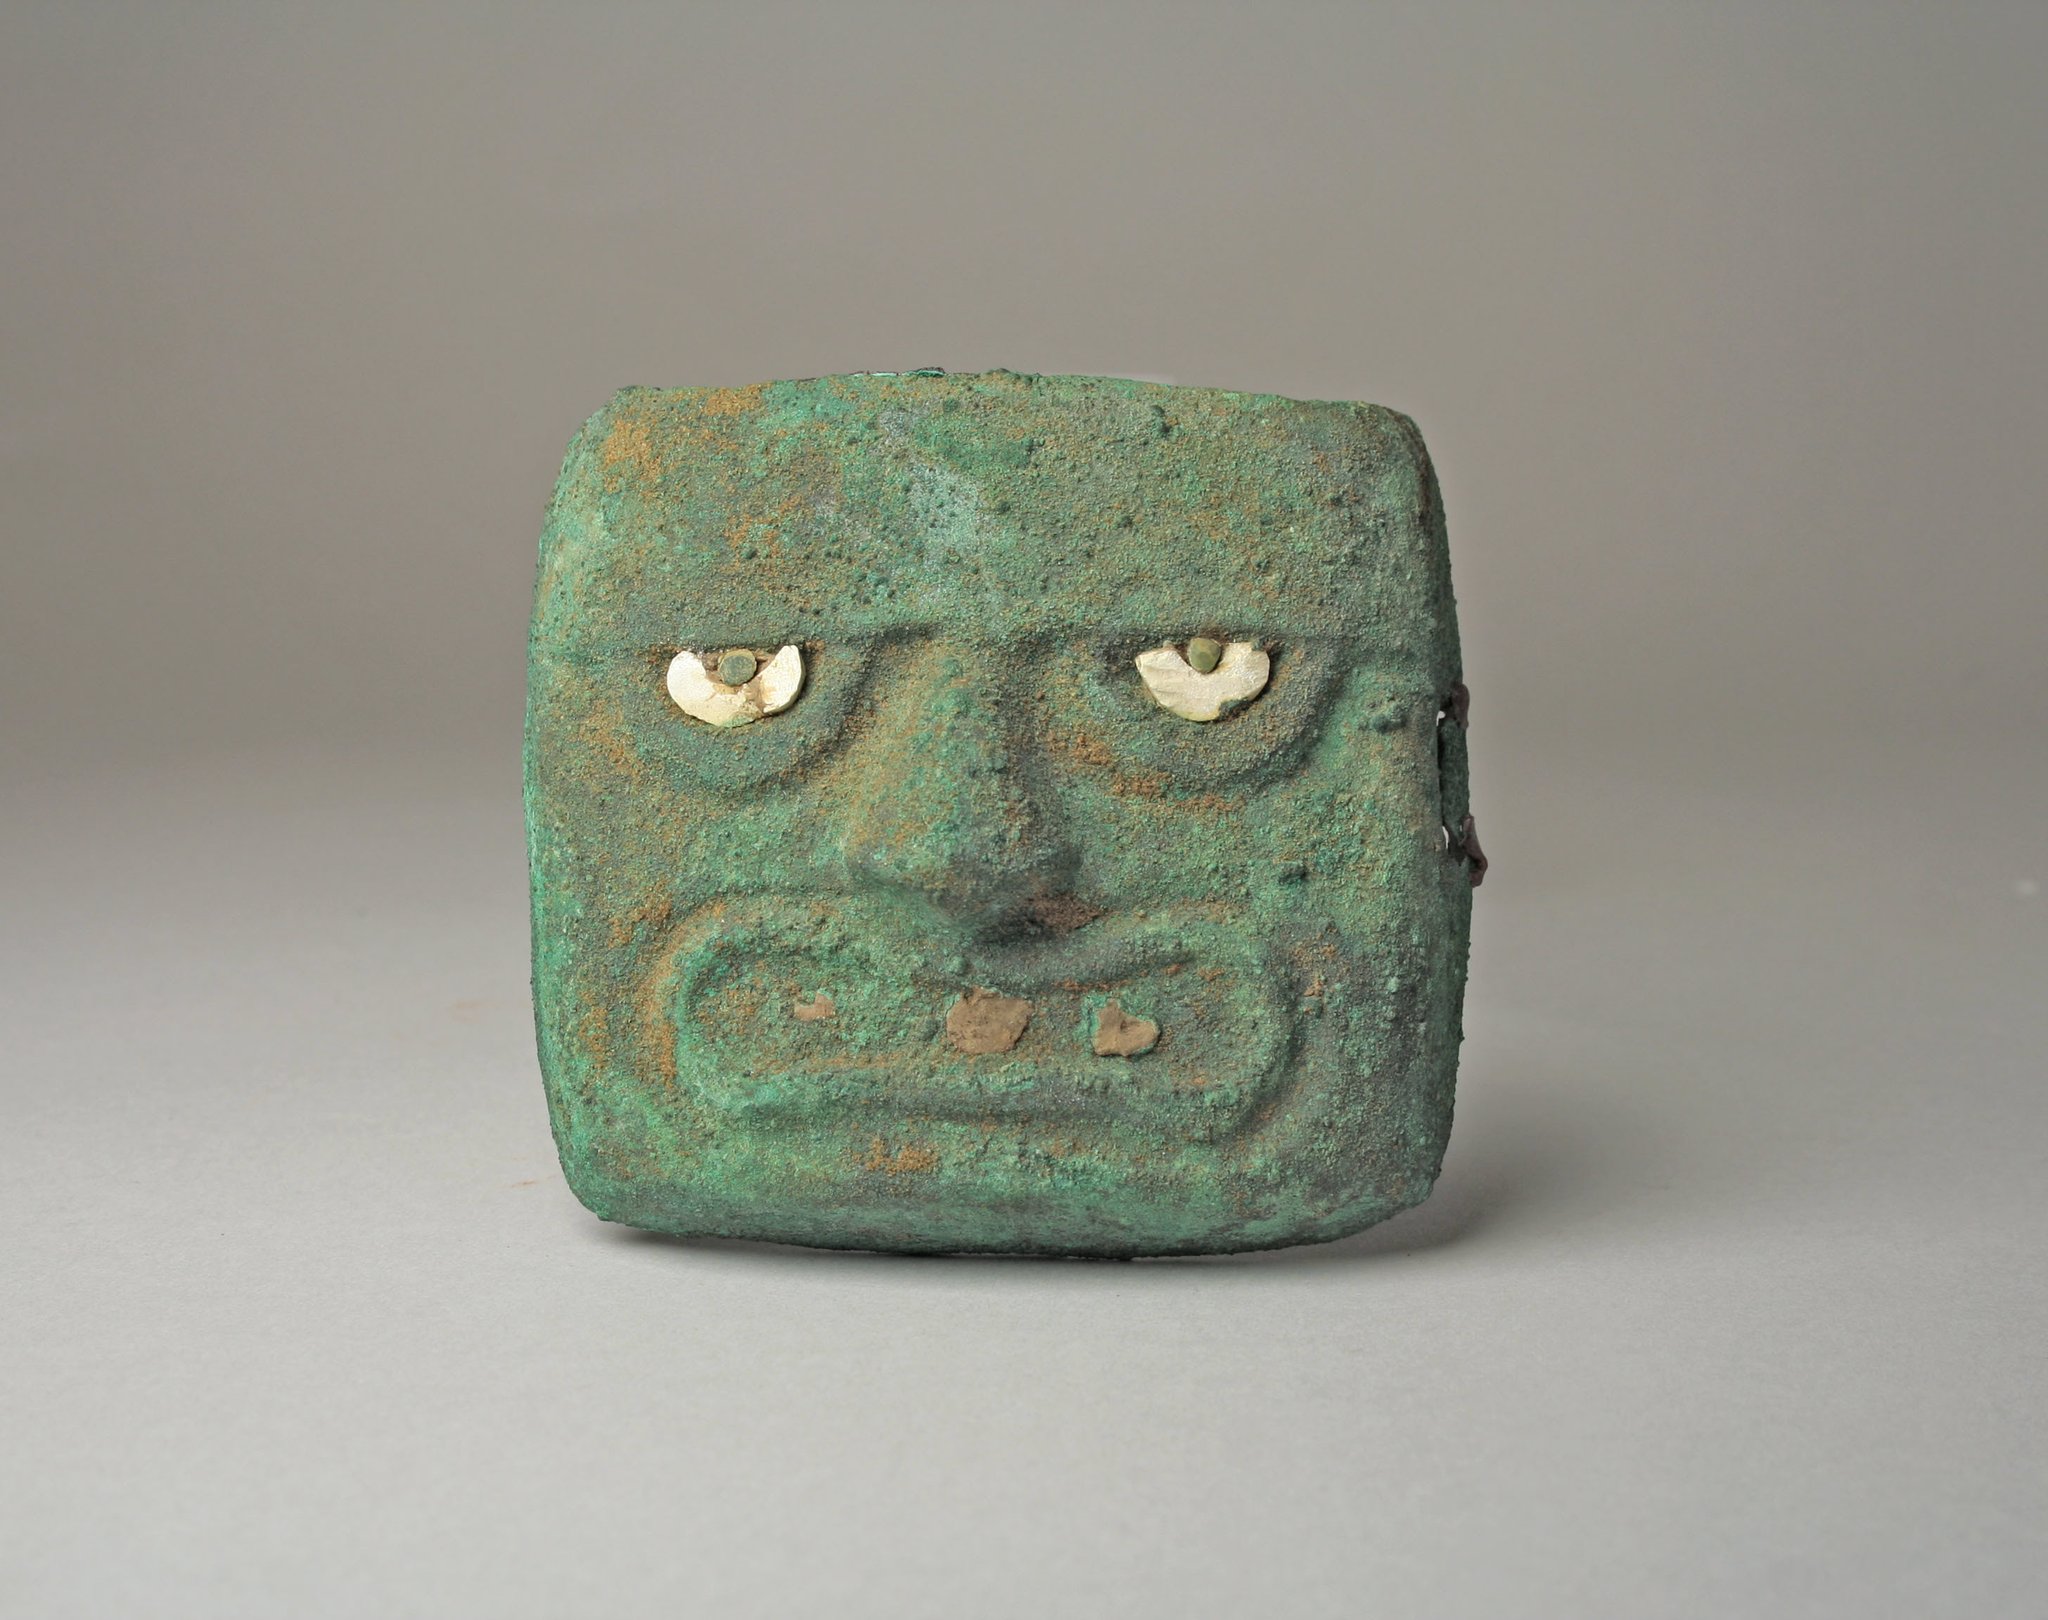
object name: ornament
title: Face Mask Ornament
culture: moche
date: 501-700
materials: gilt copper, shell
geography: peru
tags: masks